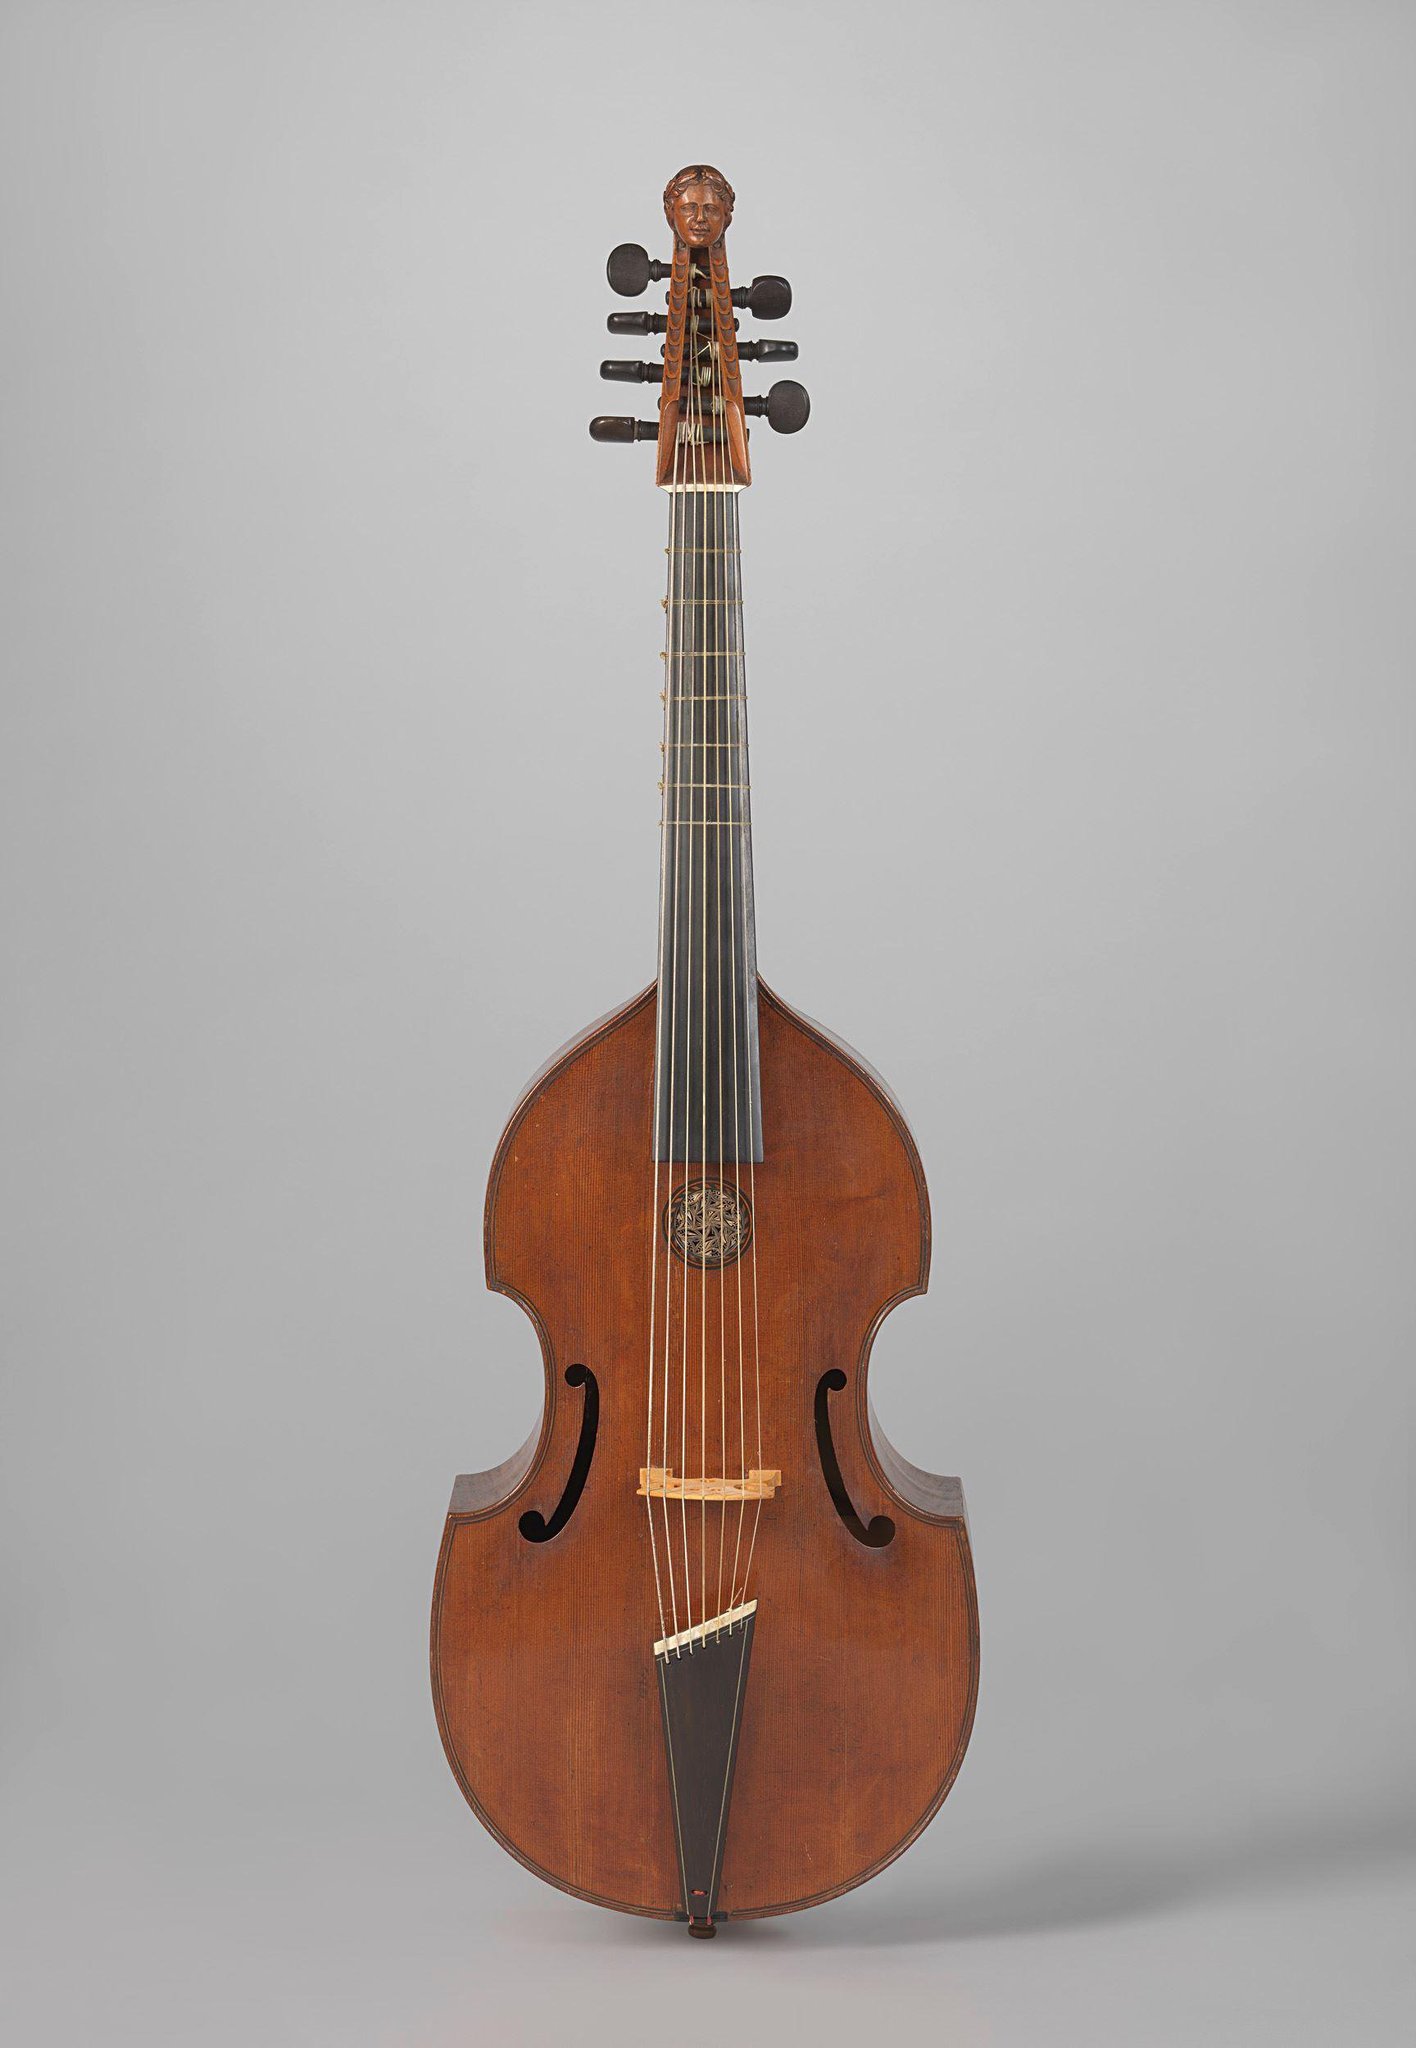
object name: bowed instrument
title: Bass viol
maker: pieter rombouts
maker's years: 1667-1740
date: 1708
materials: wood, intestine, metal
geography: amsterdam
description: The bass viol served as a solo instrument or provided the bass part in chamber ensembles. Its six or seven strings are stroked with a bow. Made from gut, the frets on the viol are wrapped around the instrument’s neck. They help the player in finding the right tone while also contributing to the quality of the sound. The stringed instruments crafted by the Amsterdam violin maker Pieter Rombouts were highly sought after.